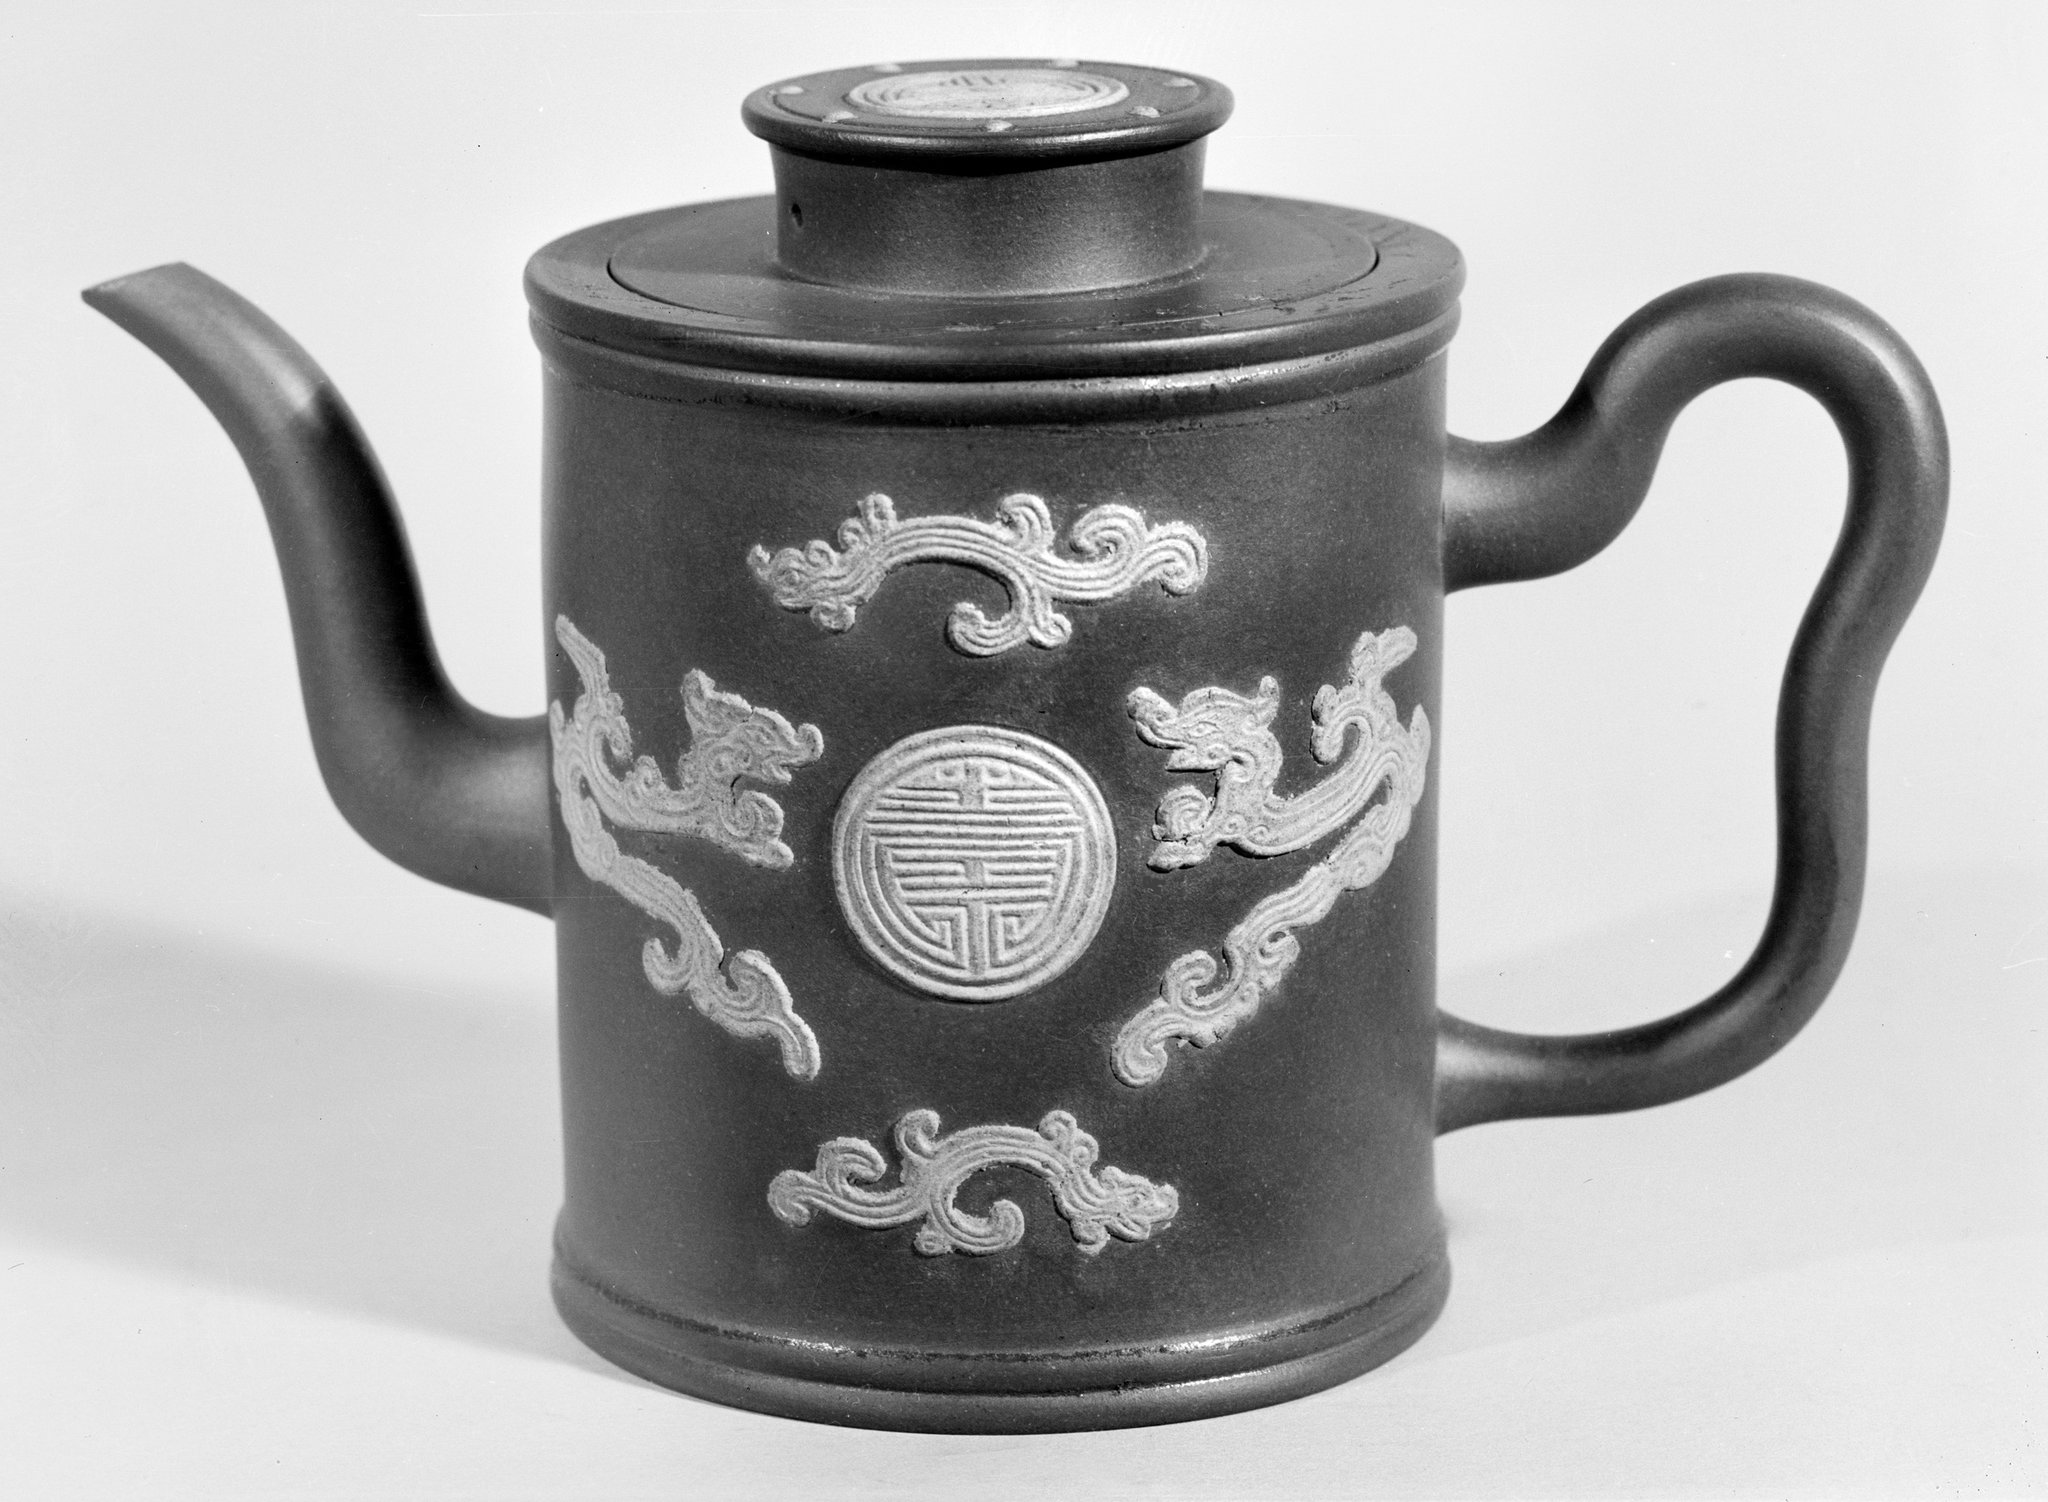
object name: teapot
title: Teapot with chi dragons and character of longevity (shou)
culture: chinese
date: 1801-1900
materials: stoneware